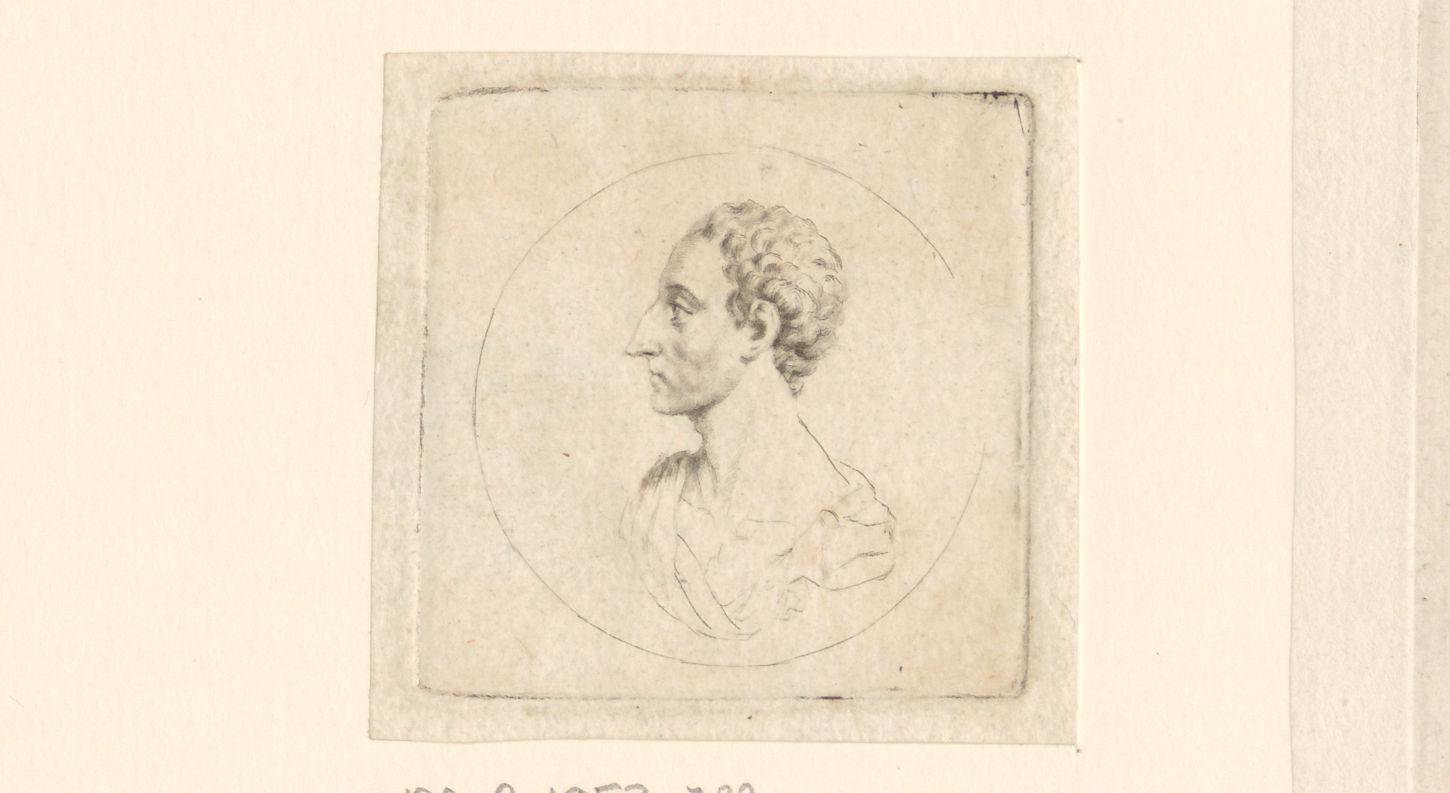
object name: print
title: Portret van onbekende man, in profiel naar links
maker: thomas worlidge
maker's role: print maker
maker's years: 1700-1766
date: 1754-1766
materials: paper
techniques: drypoint, etching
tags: anonymous historical person portrayed alone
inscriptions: collector's mark: Lugt 2228, collector's mark: Lugt 2760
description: Prent mogelijk uit de serie A Select Collection of Drawings from Curious Antique Gems. Worlidge maakte prenten voor deze serie vanaf ca. 1754.